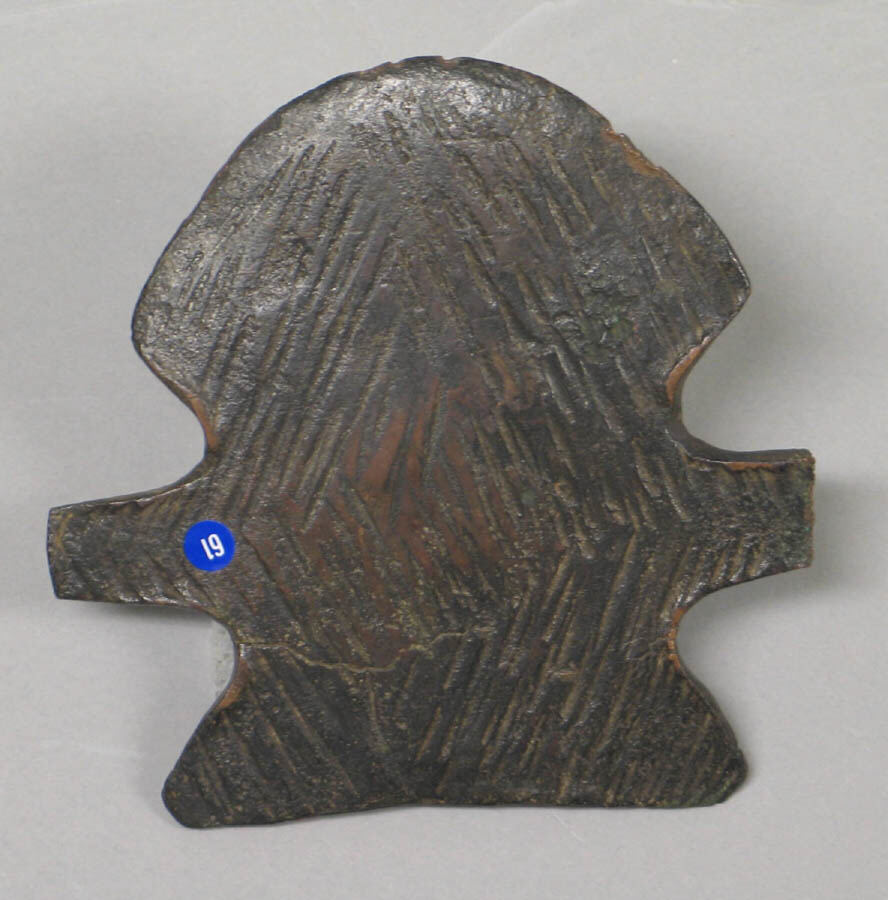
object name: anthropomorph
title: Eccentric Anthropomorph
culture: indian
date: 1500-500 BCE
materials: copper